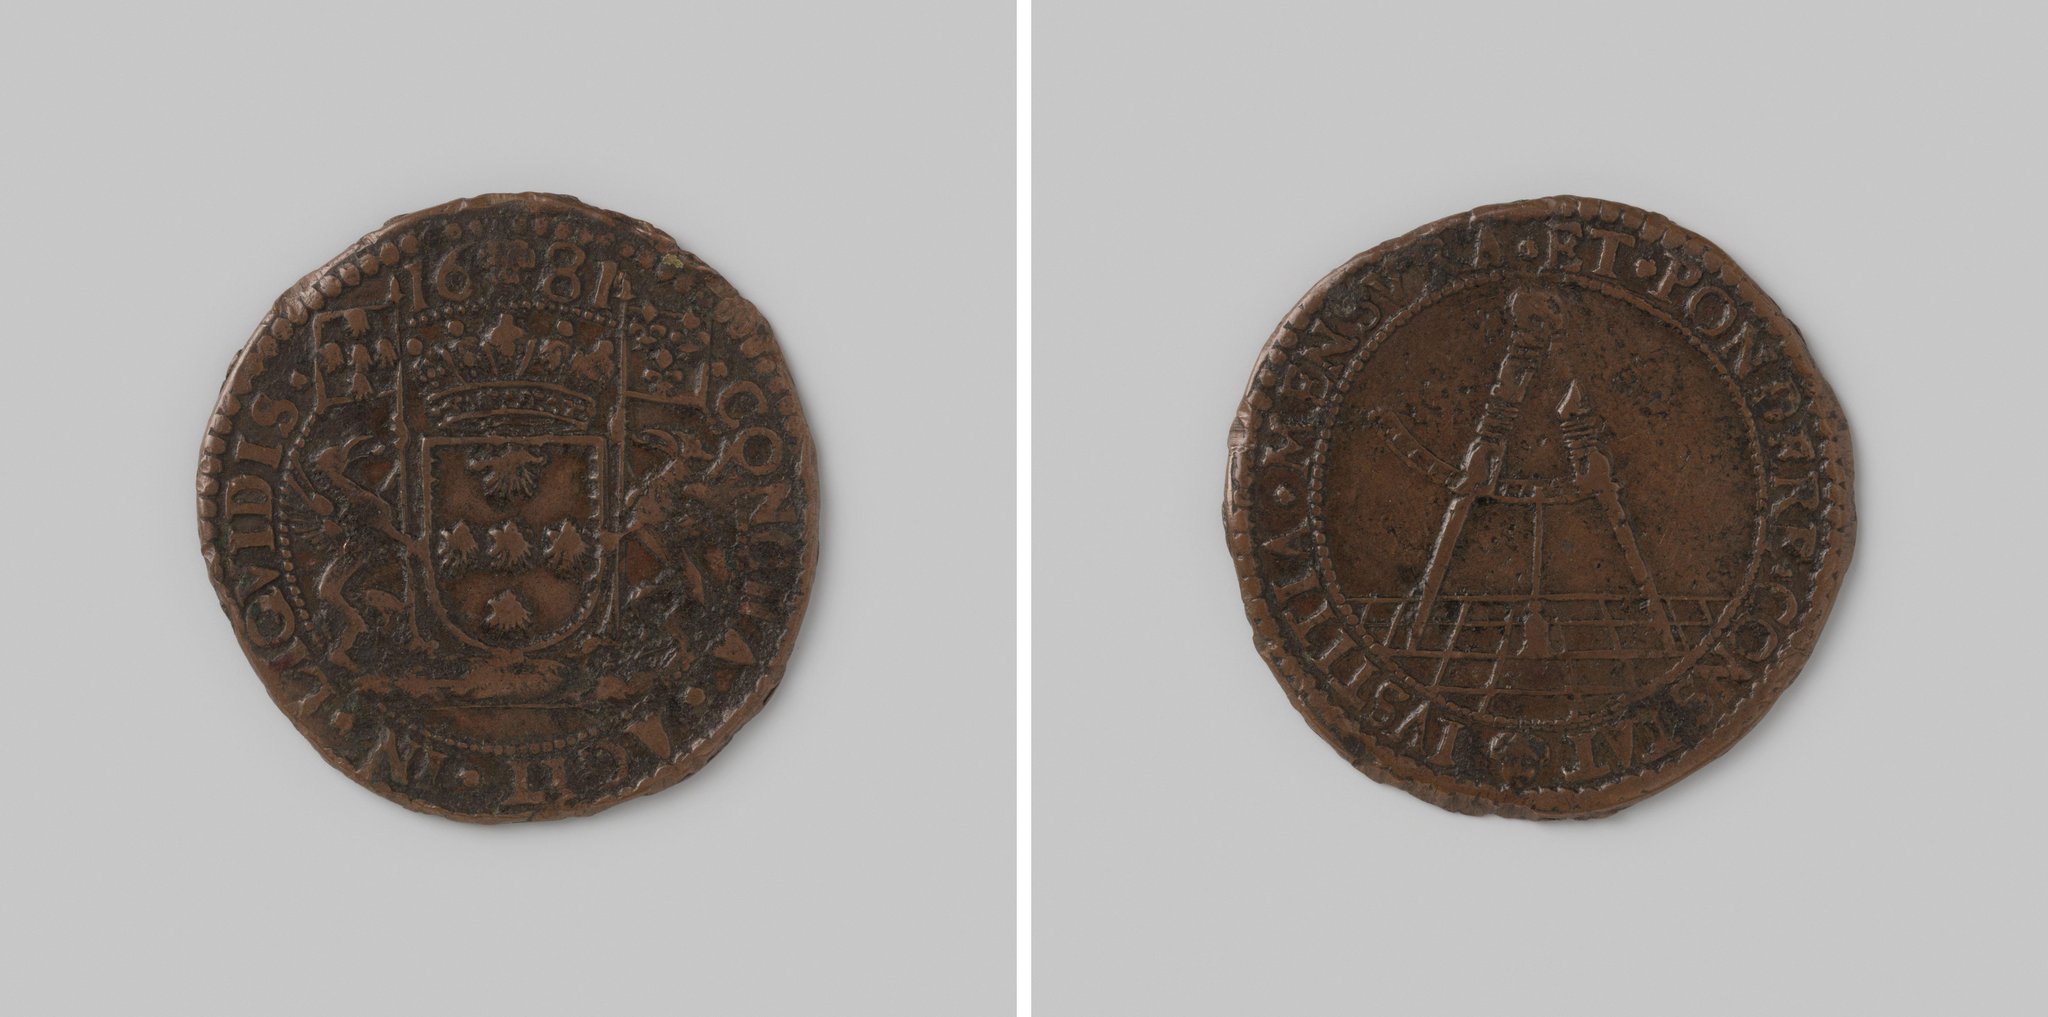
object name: jeton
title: Rekenpenning uit Brussel voor Van der Noot 1681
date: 1681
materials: copper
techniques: striking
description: Koperen penning, op de voorzijde het gekroonde wapenschild van Van der Noot, met griffioenen met vaandels als dragers, met omschrift, op de keerzijde een passer met schietlood boven een kaart, met omschrift.